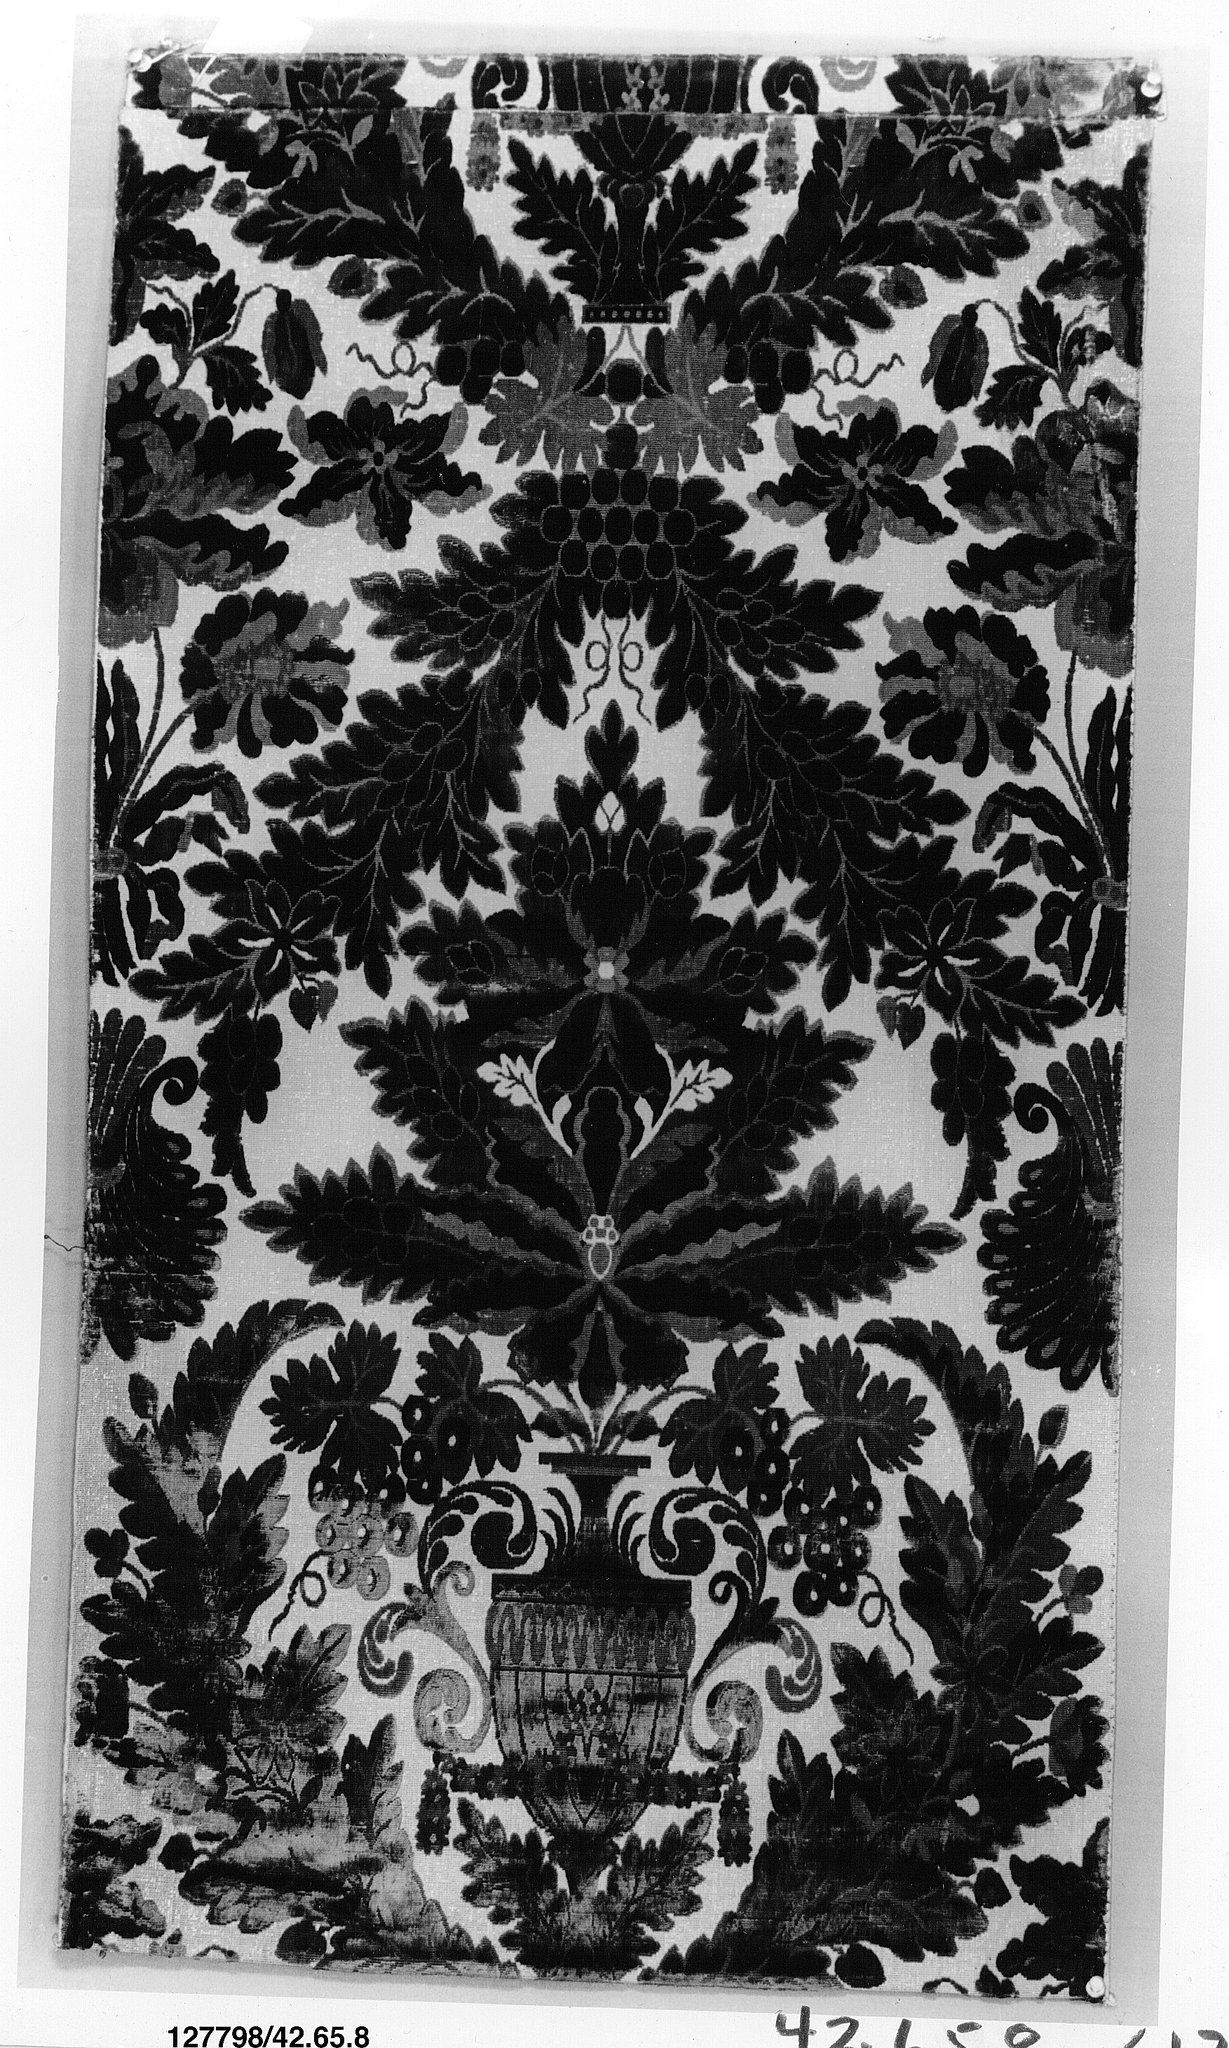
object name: panel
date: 1801-1833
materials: metal thread, silk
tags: flowers